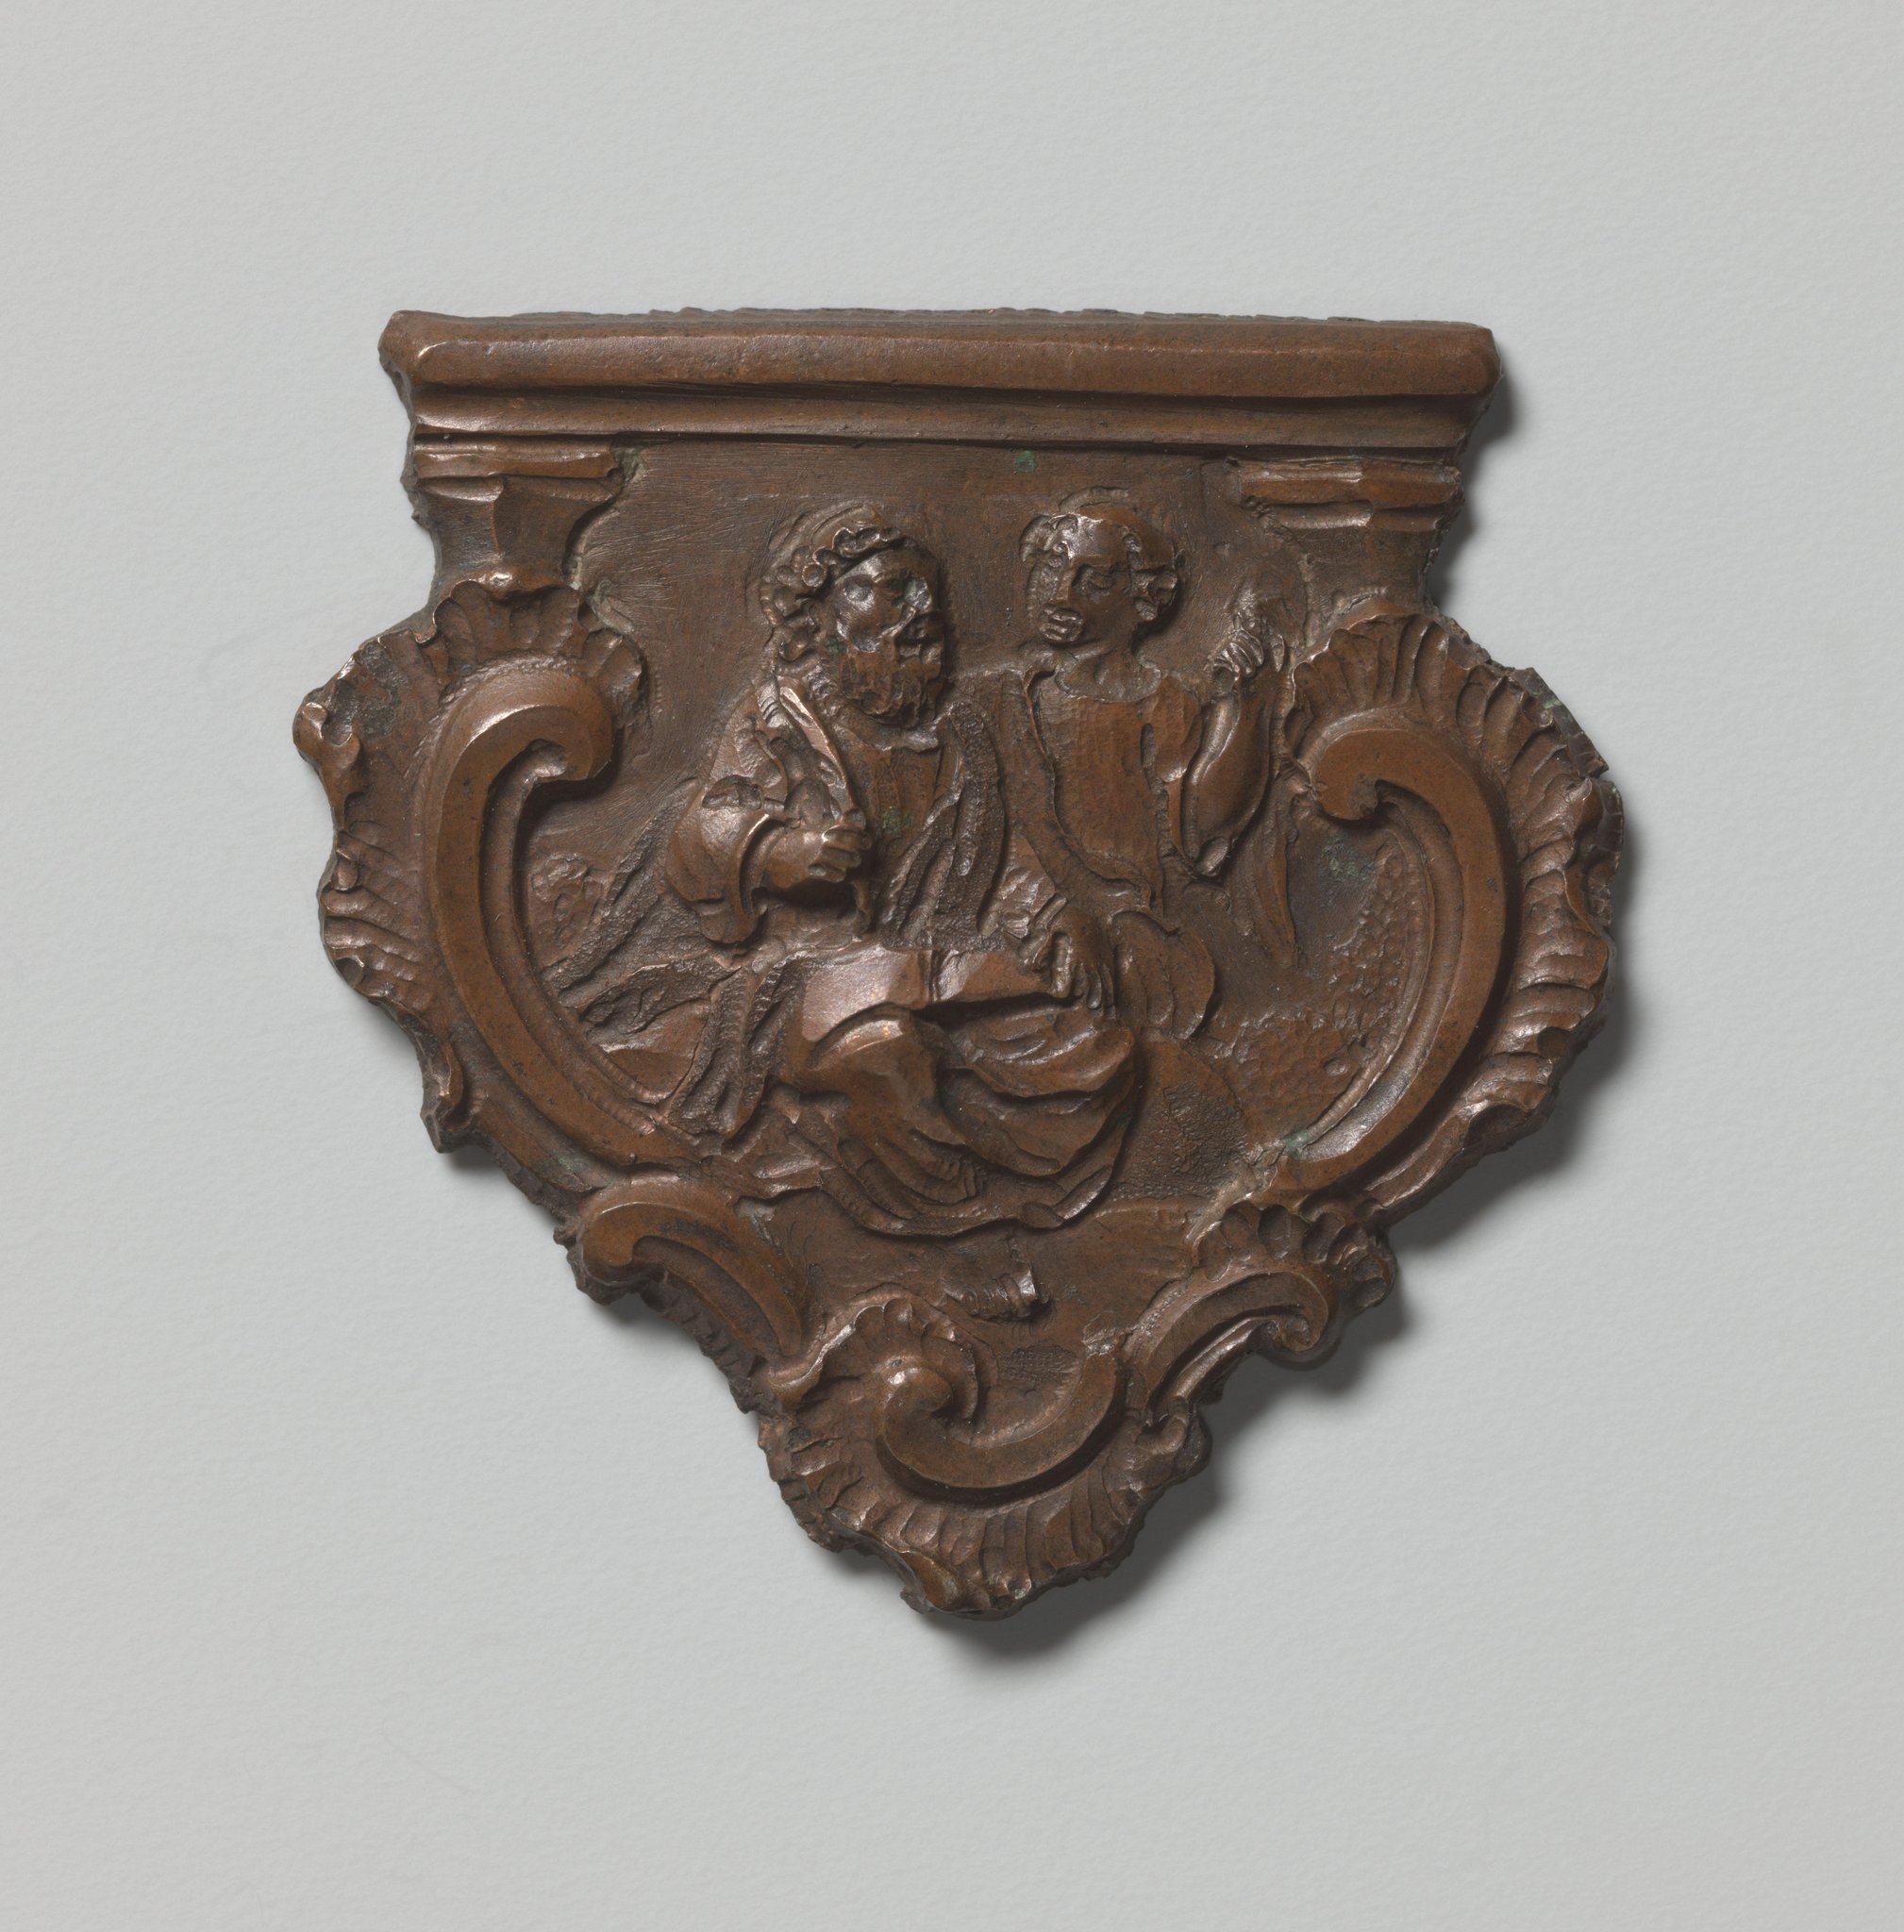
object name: boekslot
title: Model voor een klamp van een boekslot met de evangelist Mattheus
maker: Anonymous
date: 1750-1775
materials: copper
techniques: metalworking, cutting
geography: amsterdam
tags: st. matthew writing the gospel, usually the angel present, dictating or assisting him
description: Model van roodkoper voor een gietvorm van een klamp van een boekslot. De voorstelling toont de evangelist Mattheus met de engel en is gevat in een rococo-ornament, gevormd door drie naar binnen gekeerde c-voluten en daartussen twee kleine, naar buiten gekeerde c-voluten. De bovenzijde is recht.